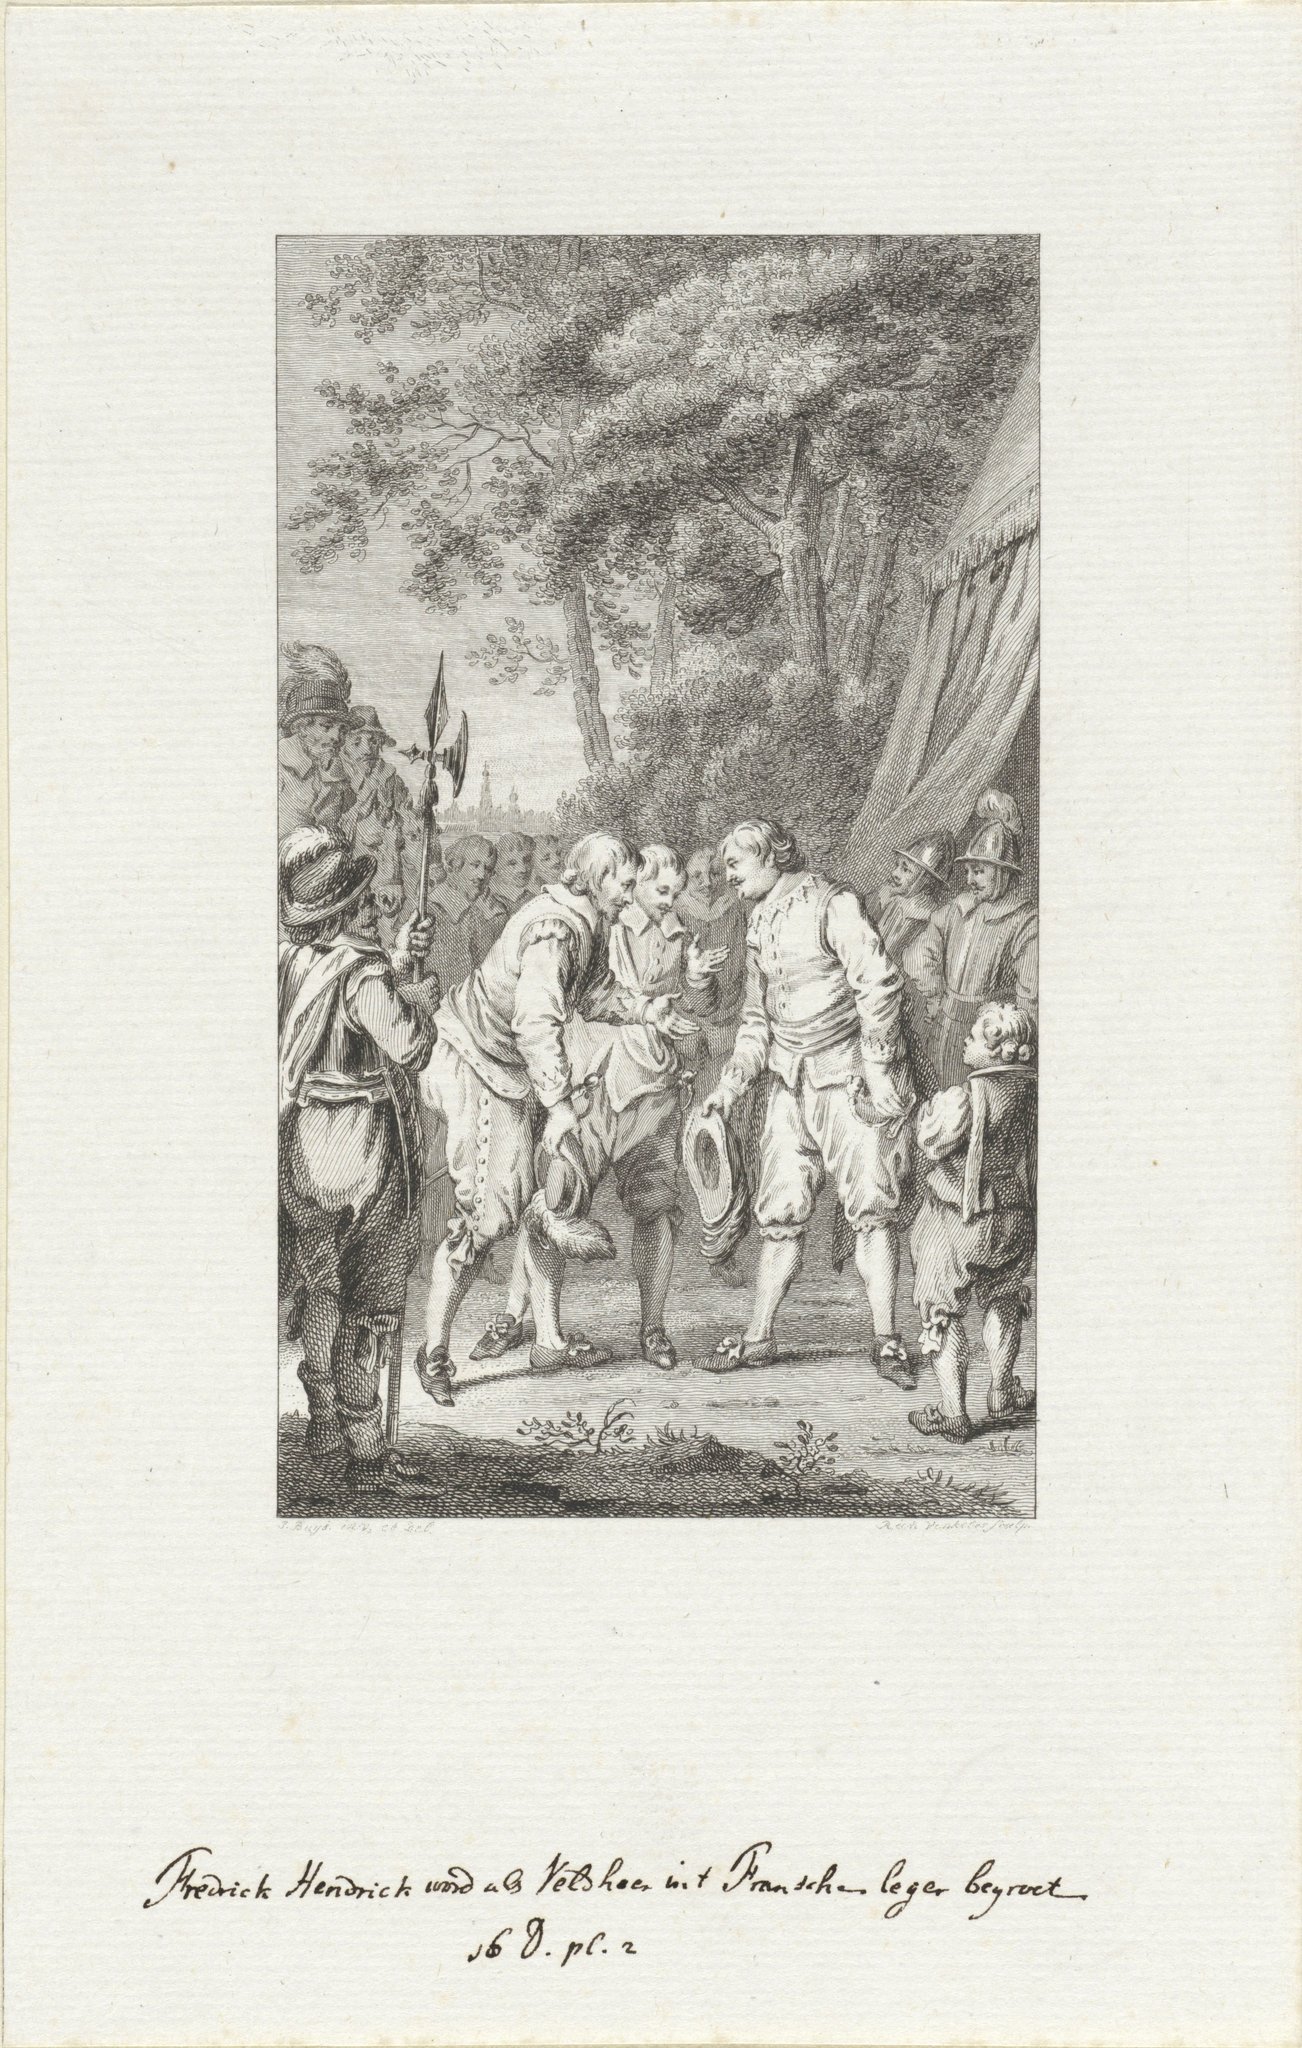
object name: print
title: Frederik Hendrik wordt als veldheer in het Franse leger begroet, 1635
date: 1786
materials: paper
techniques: etching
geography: amsterdam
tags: delft, the hague, frederick henry (prince of orange), proclamation of new government, siege, position war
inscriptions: collector's mark: Lugt 240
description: Gebruikt als illustratie in: Jacobus Kok, Vaderlandsch Woordenboek, Johannes Allart, Amsterdam 1785-1799, 35 delen, dl. XVI, pl. II.